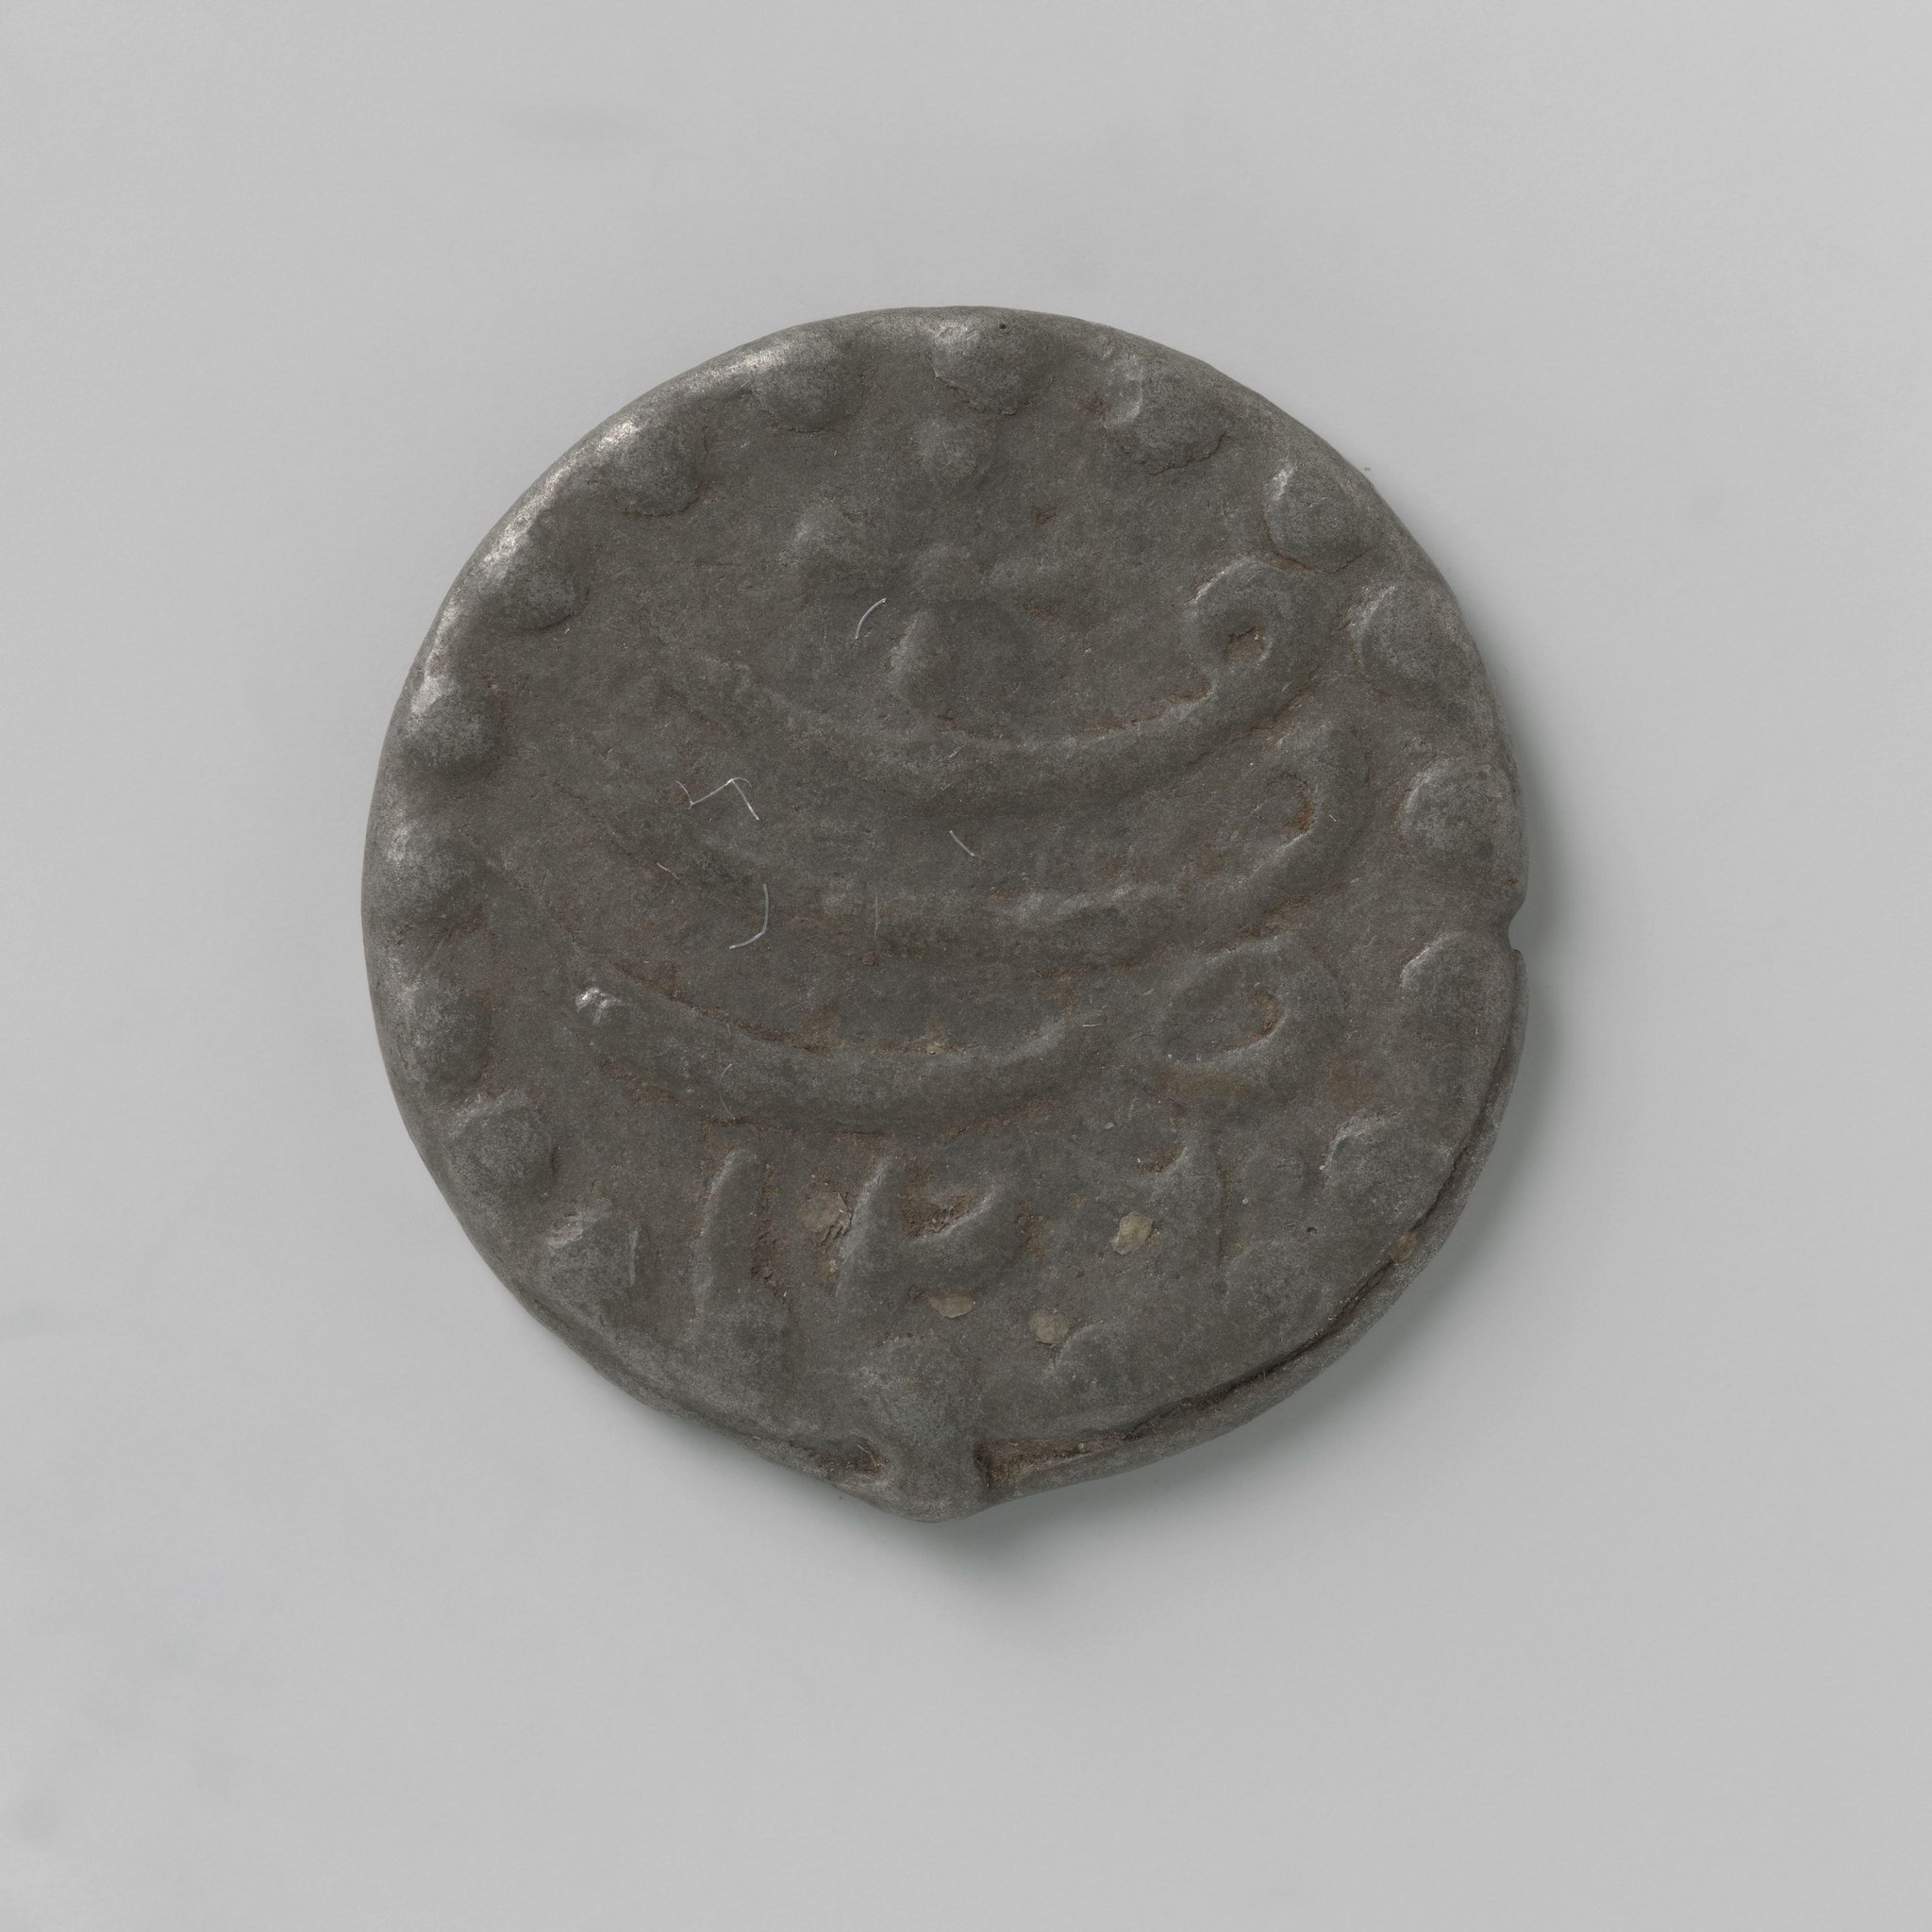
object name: coin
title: Atjeh, Sumatra, sultan Ala ed-din Mansoer II, kasja, AH 1260 (1844)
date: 1844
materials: tin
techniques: casting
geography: aceh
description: Tinnen munt. Voorzijde: drieregelig opschrift in Arabische lettertekens. Keerzijde: drieregelig opschrift in Arabische lettertekens, waaronder jaartal in Islamitische jaartelling